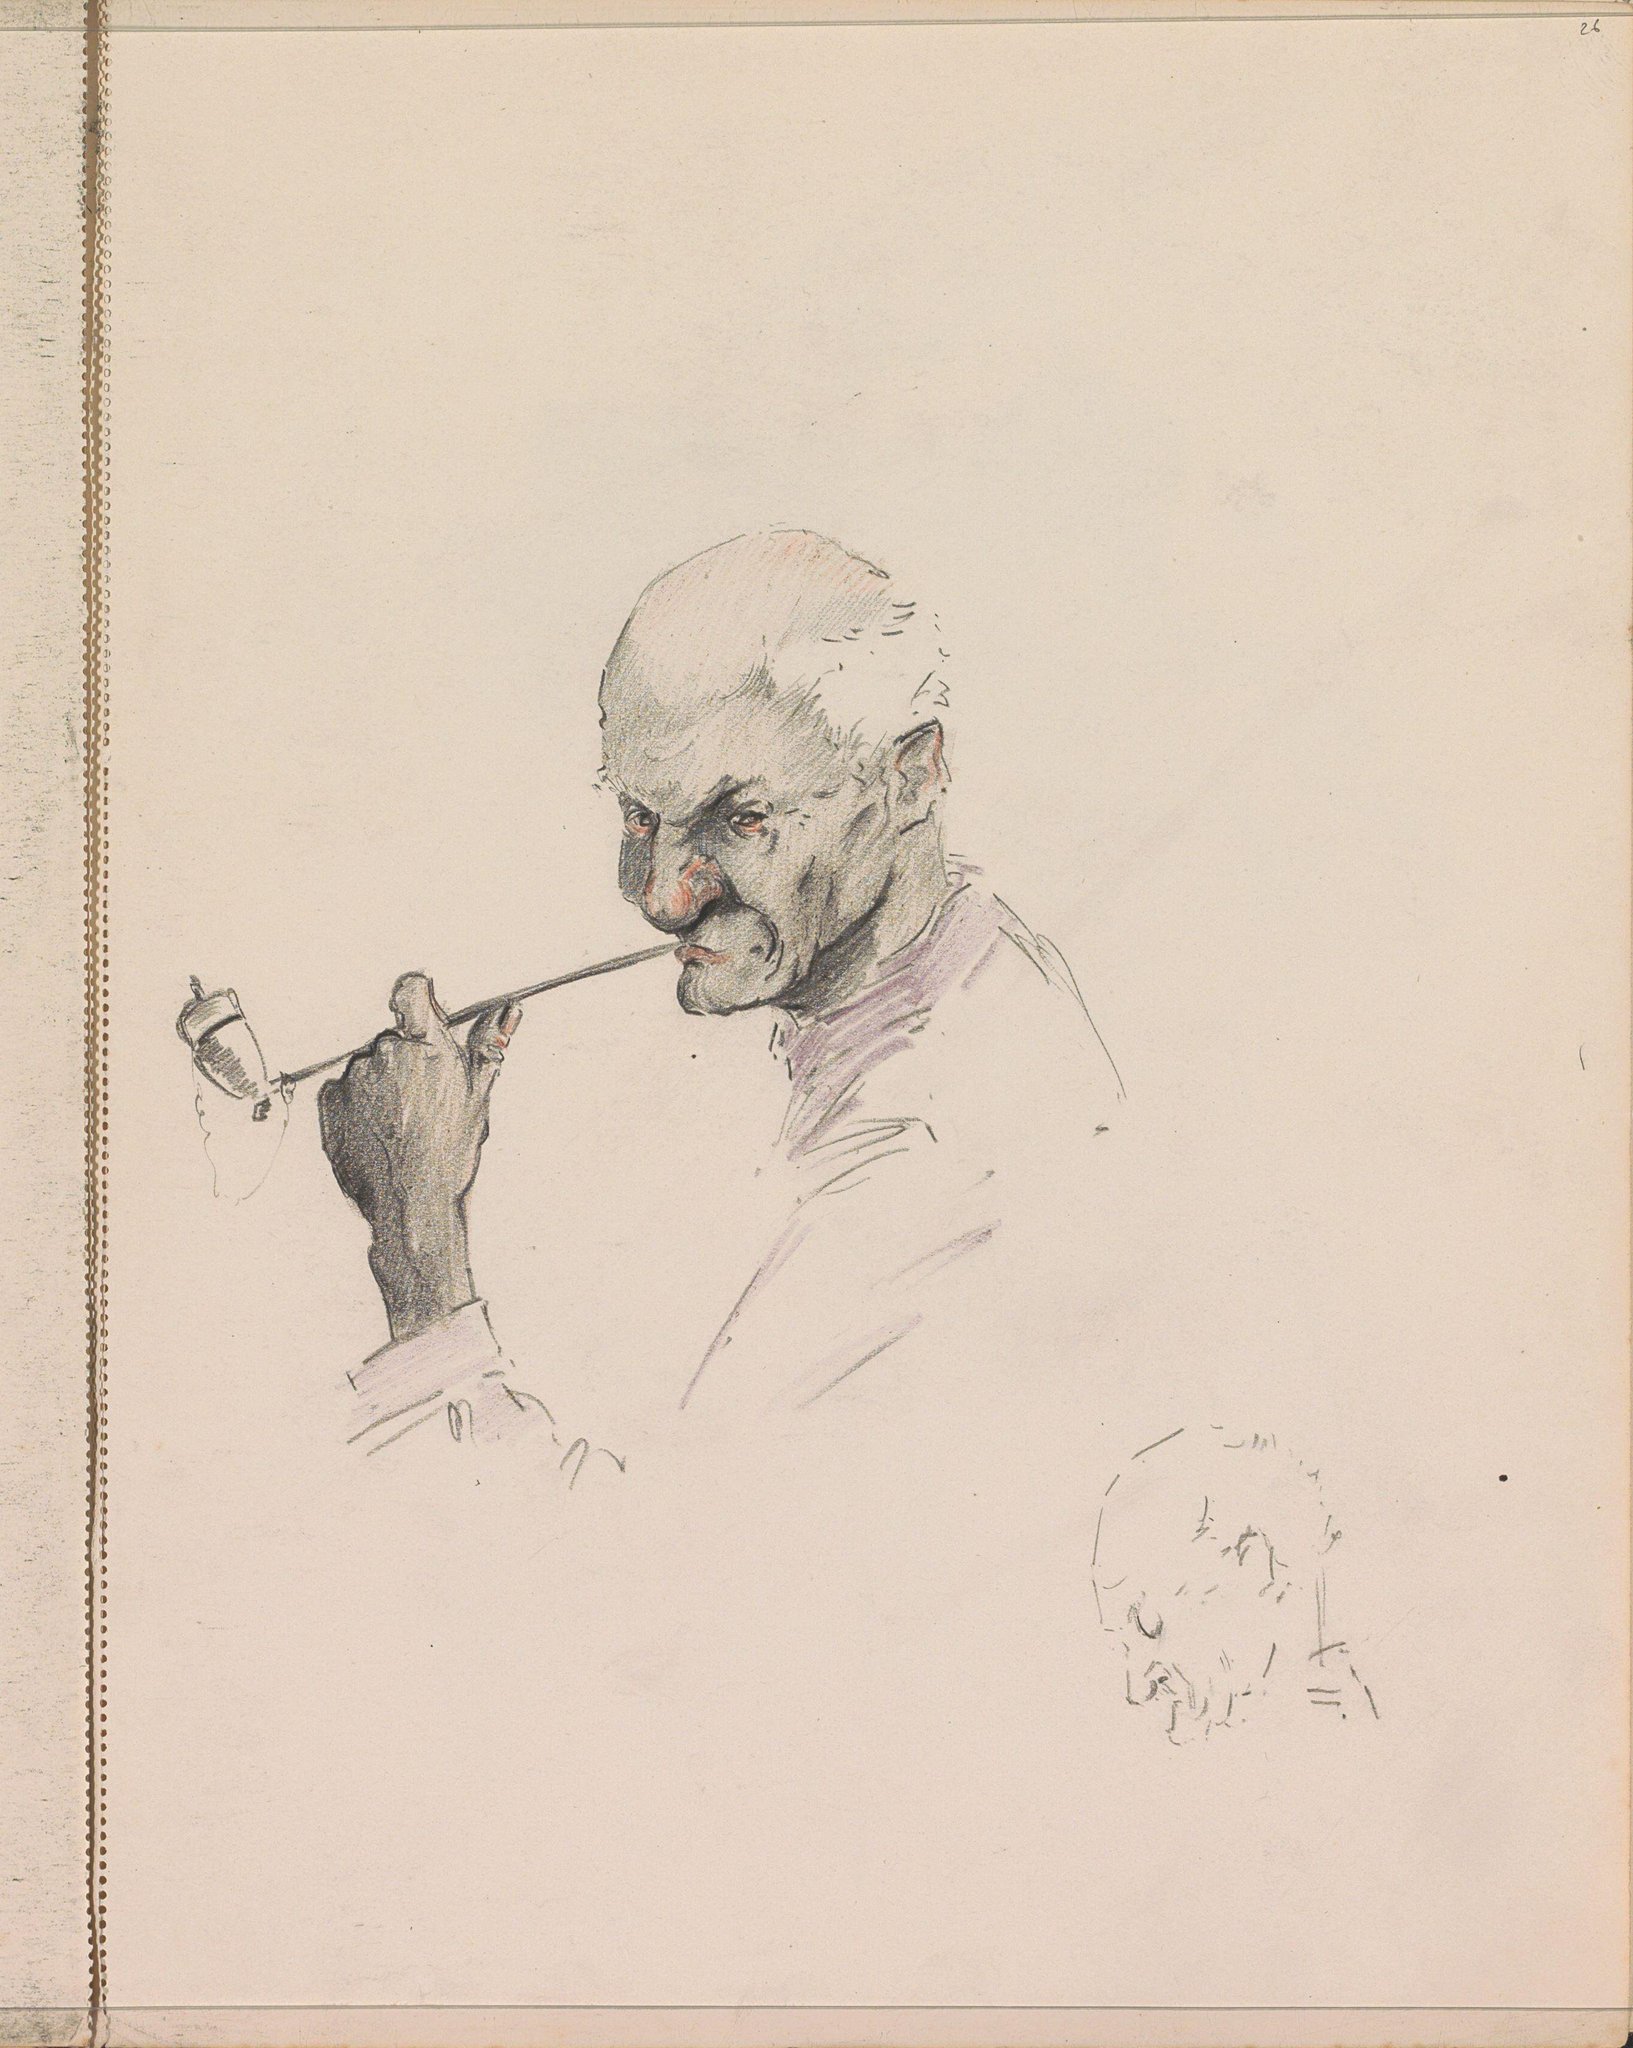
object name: sketchbook leaf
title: Kalende man met een pijp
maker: otto verhagen (i)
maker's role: draughtsman, print maker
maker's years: 1885-1951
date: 1917-1919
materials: chalk, paper, pencil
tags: head (human) (+ old male (human being)), pipe ~ tobacco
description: Tevens een studie van het hoofd van de man. Pagina 26 uit een schetsboek met 28 bladen.